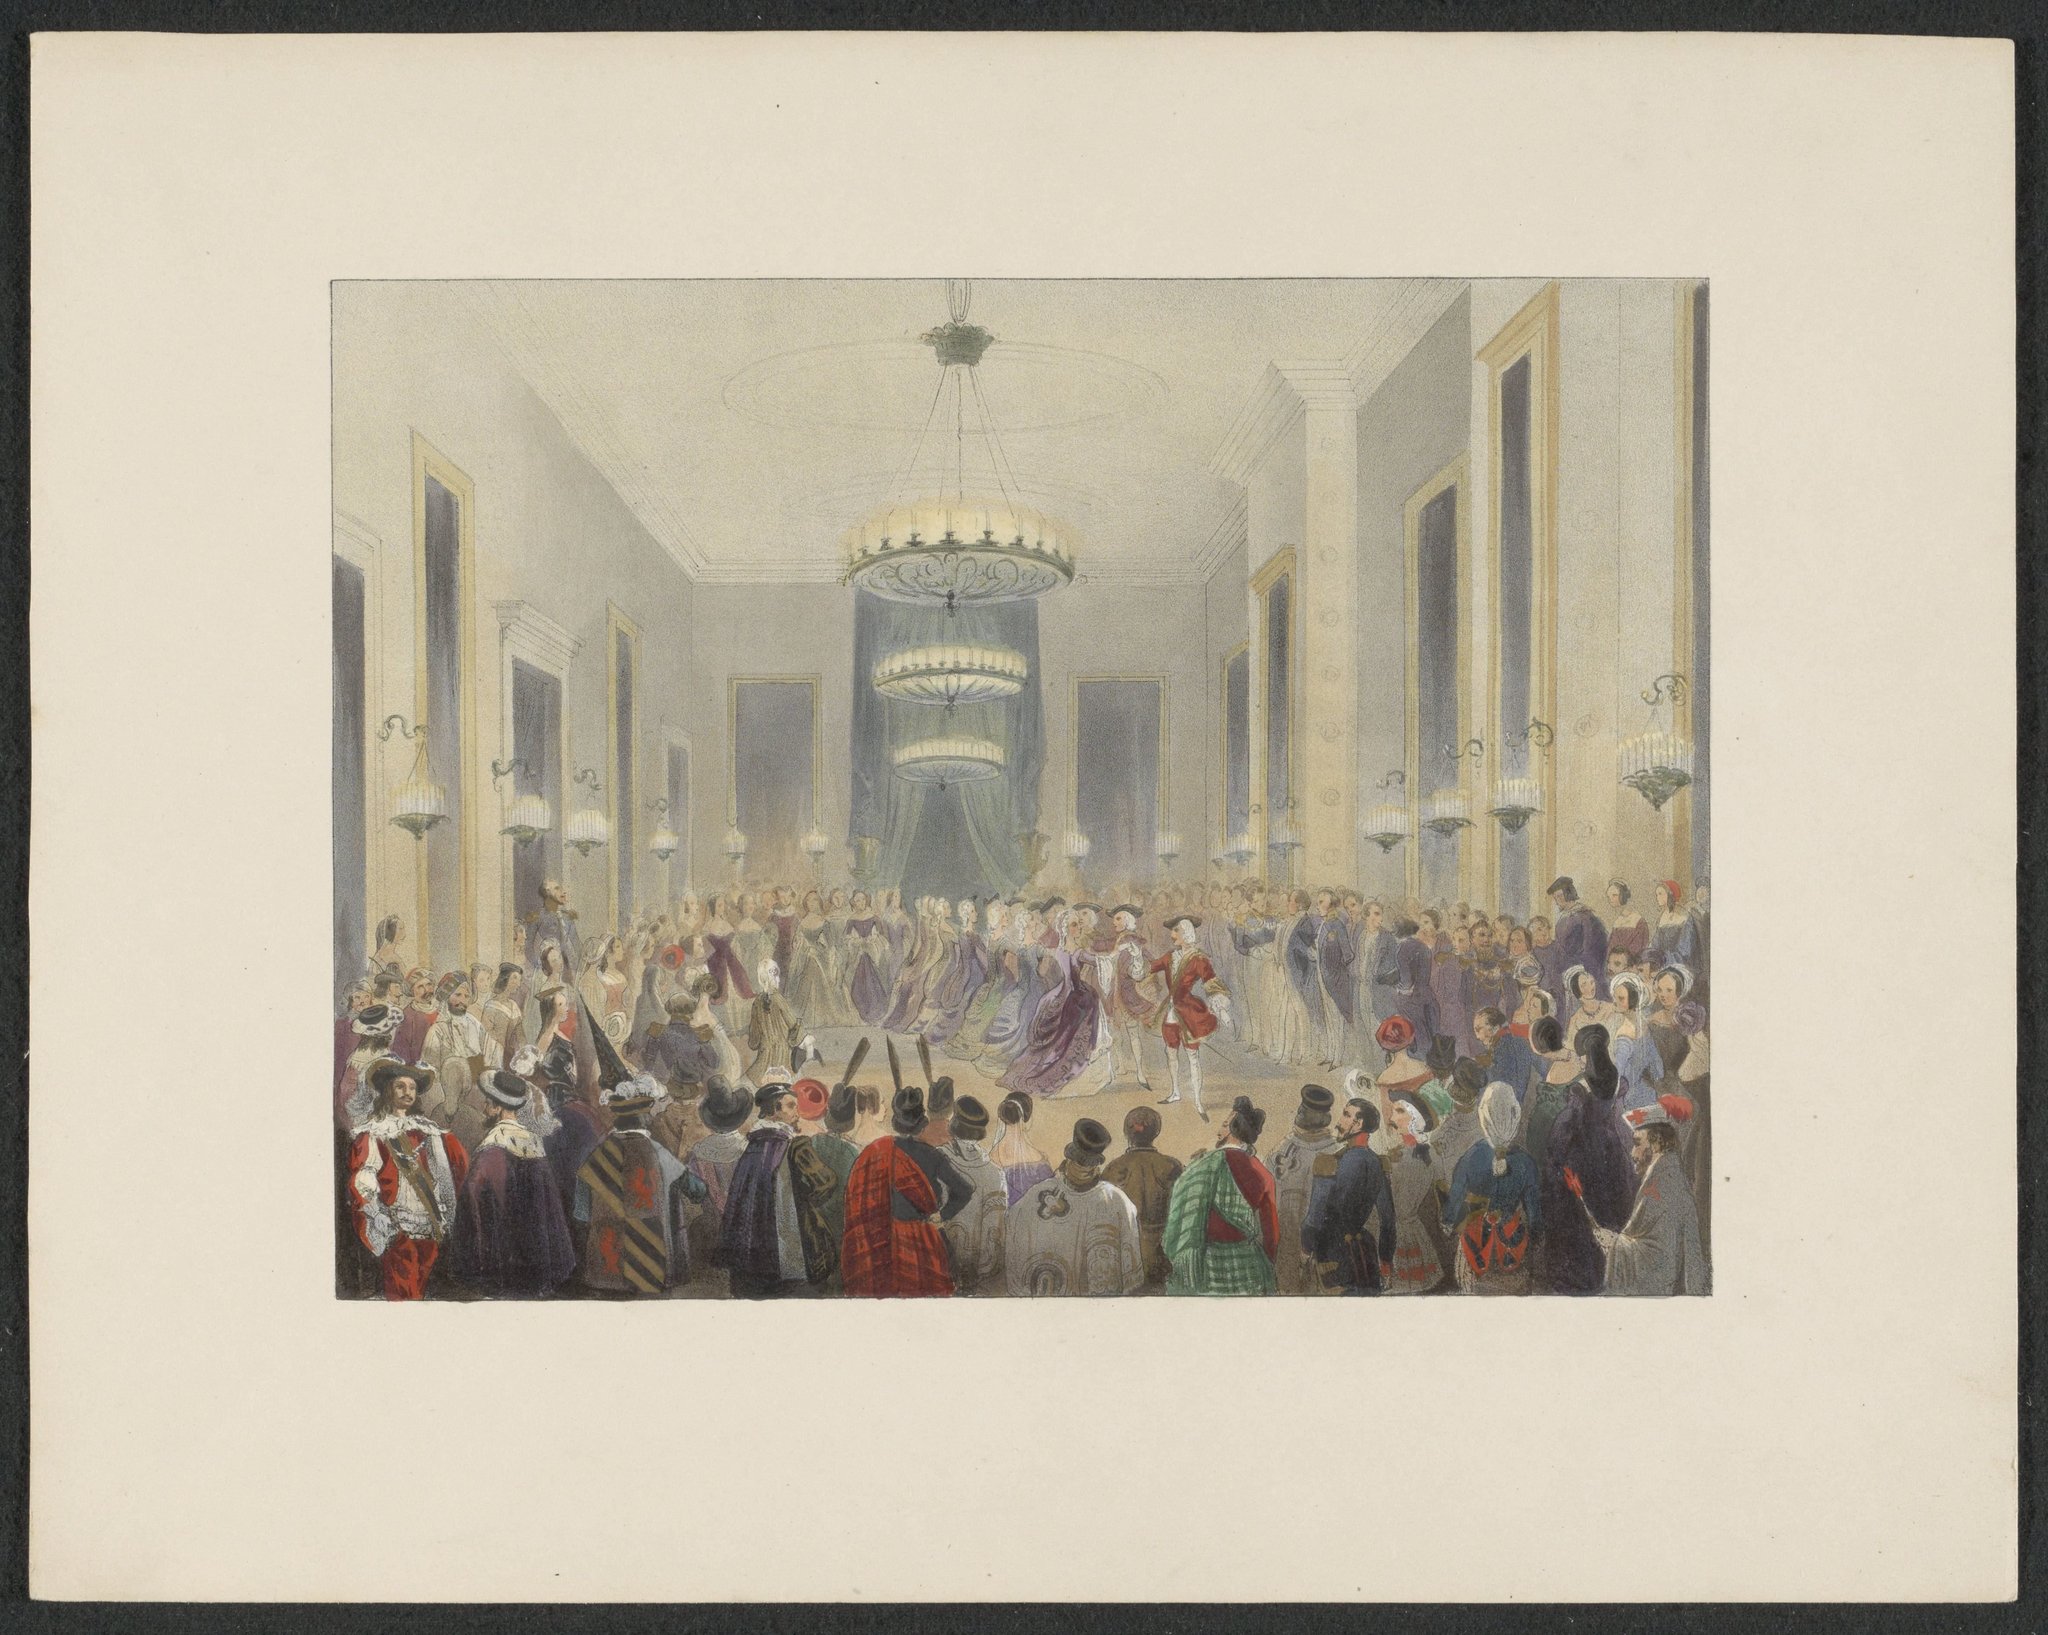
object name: print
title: Le Bal Costumé donné au Palais de S.A.R. Monseigneur le Prince d'Orange au 26 Fevrier 1845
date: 1845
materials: paper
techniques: hand coloring, lithograph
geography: the hague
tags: willem iii (koning der nederlanden), william ii of the netherlands, ball, formal dance, masquerade, masked ball, the hague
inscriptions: collector's mark: Lugt 2228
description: Balzaal waar door acht paren de pavane wordt gedanst. Links ziet koning Willem II toe. Onderdeel van het plaatwerk over het gekostumeerd bal gehouden op het paleis van de prins van Oranje (de latere koning Willem III) in Den Haag op 26 februari 1845. In een omslag met de gedrukte beschrijving door le Comte de Guldenlew.